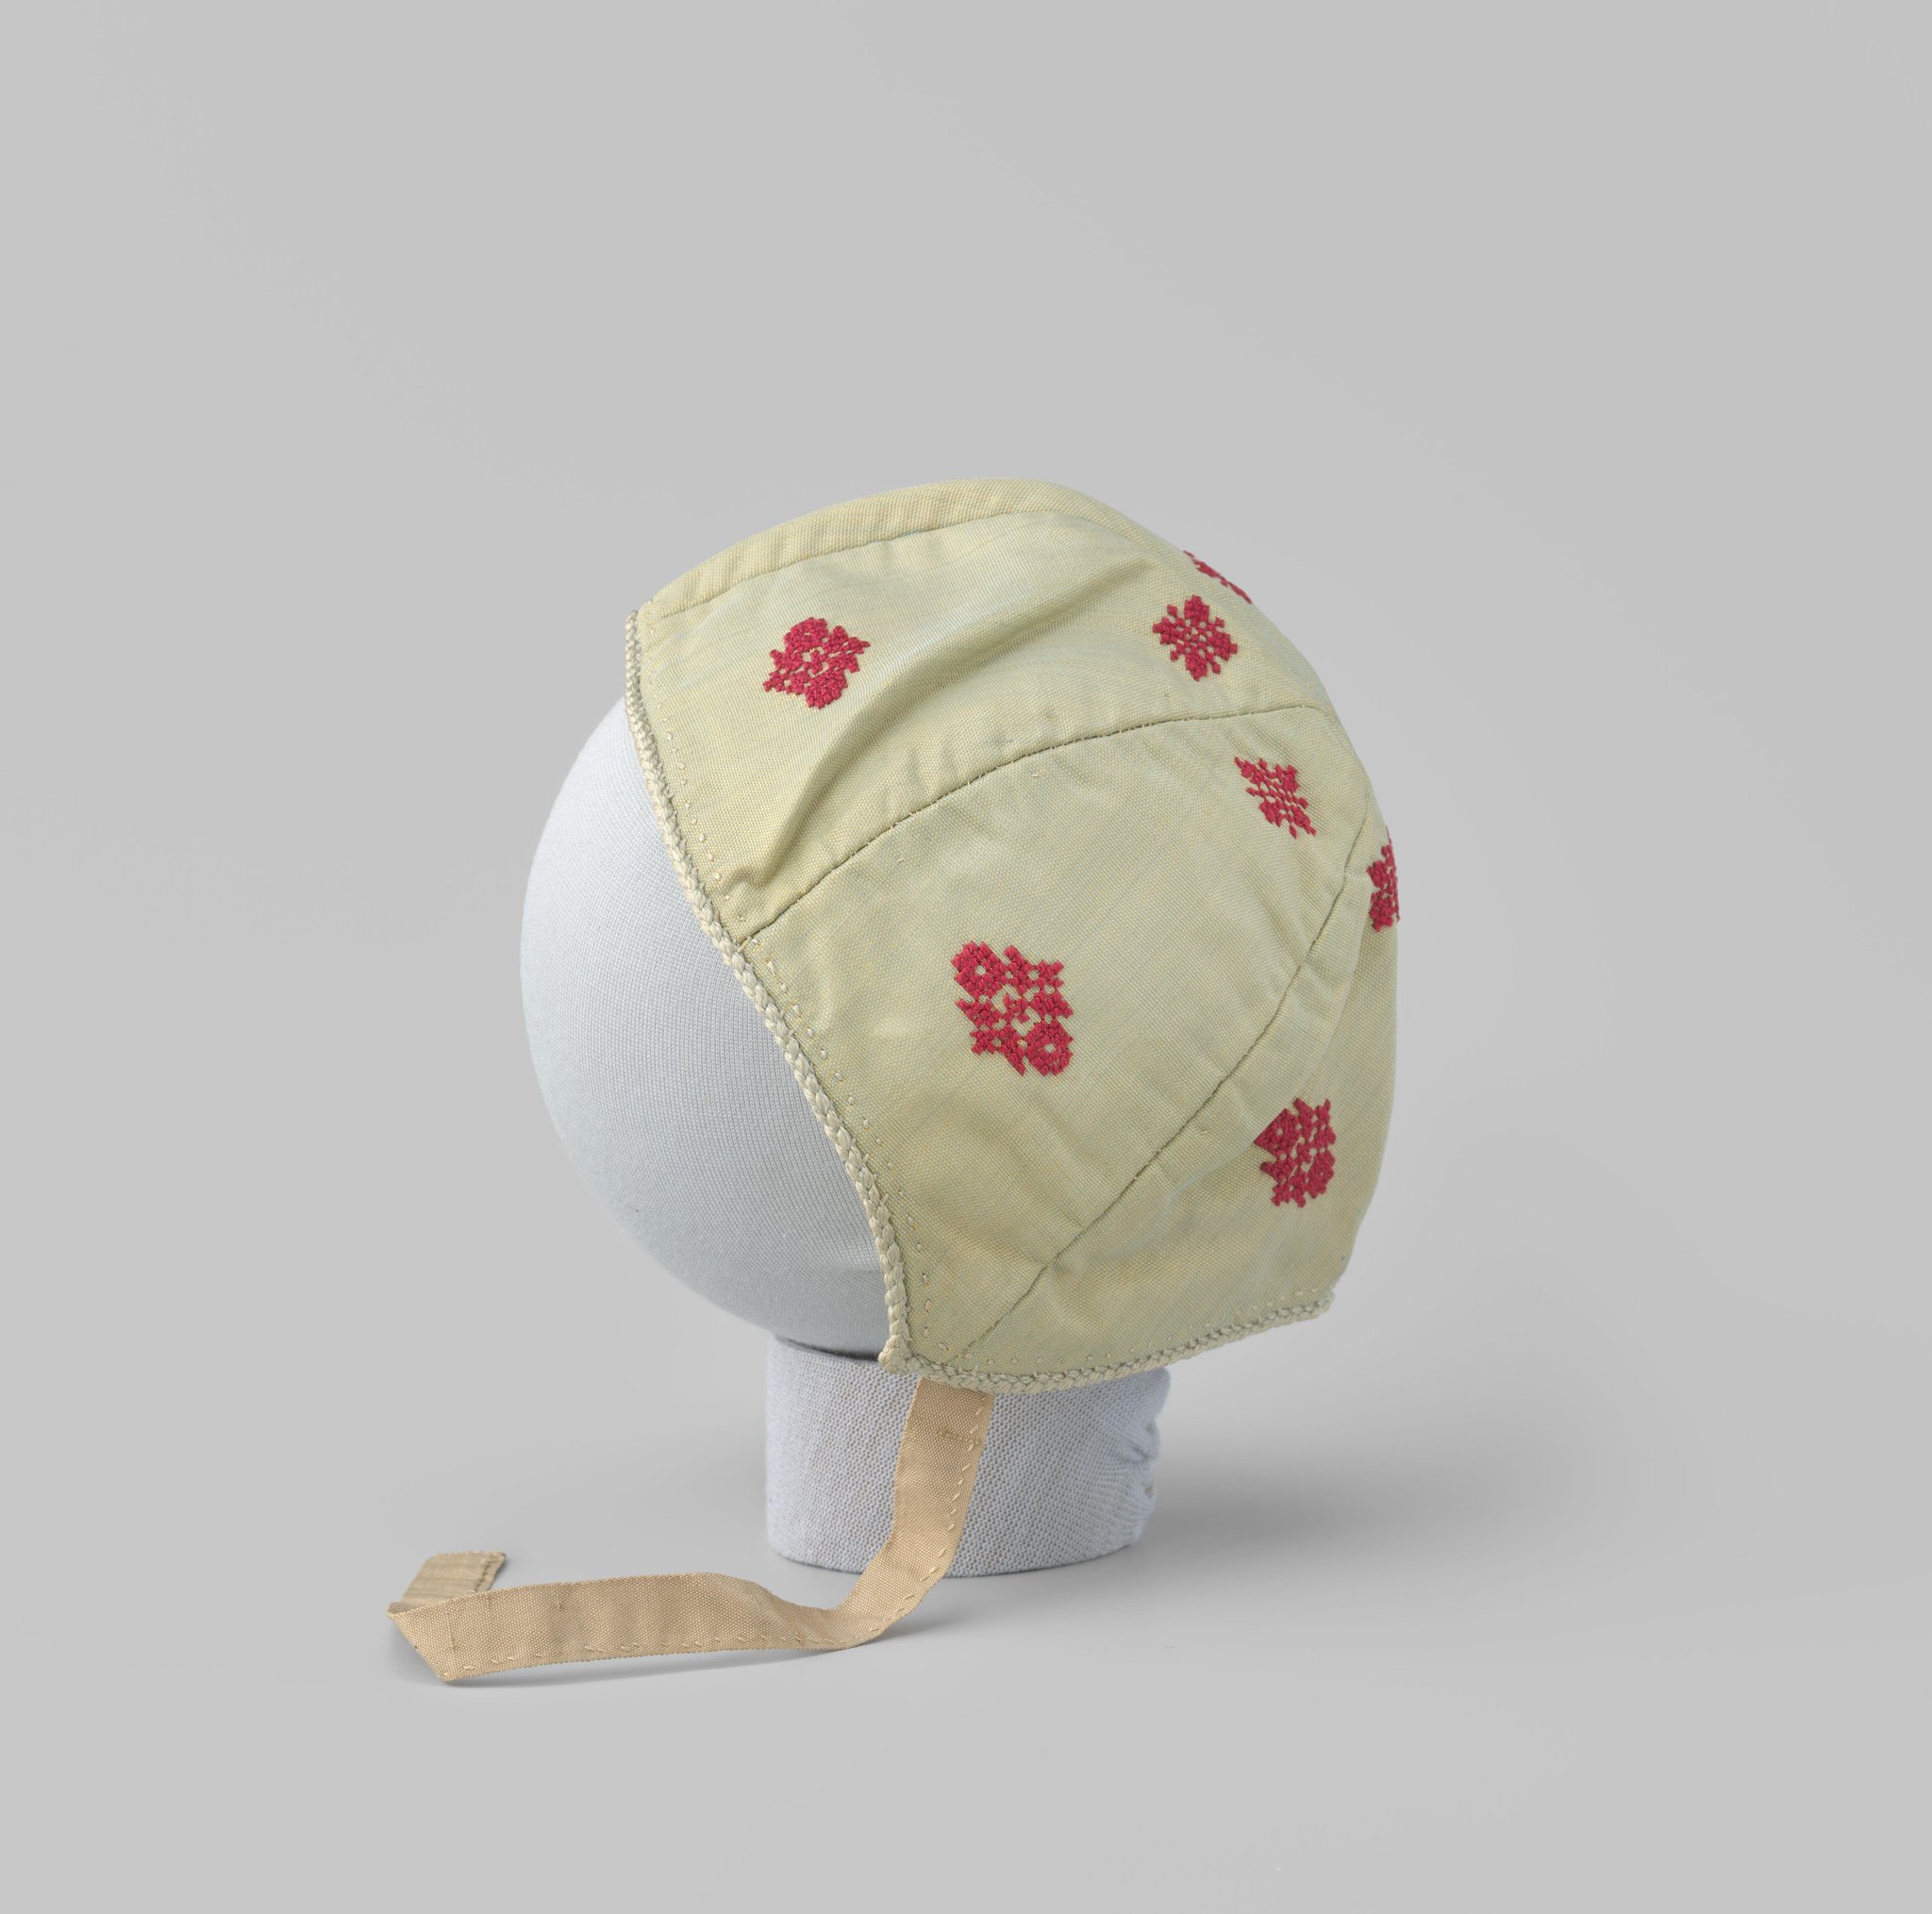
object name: cap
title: Kindermuts van fletgroene changeantzijde met rood bloempje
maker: Anonymous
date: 1700-1800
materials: silk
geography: netherlands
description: Kindermuts van fletsgroene changeantzijde met rood bloempje. Model van zes cirkelsectoren. Randversiering rondom en één lintje aan de linkerpunt.